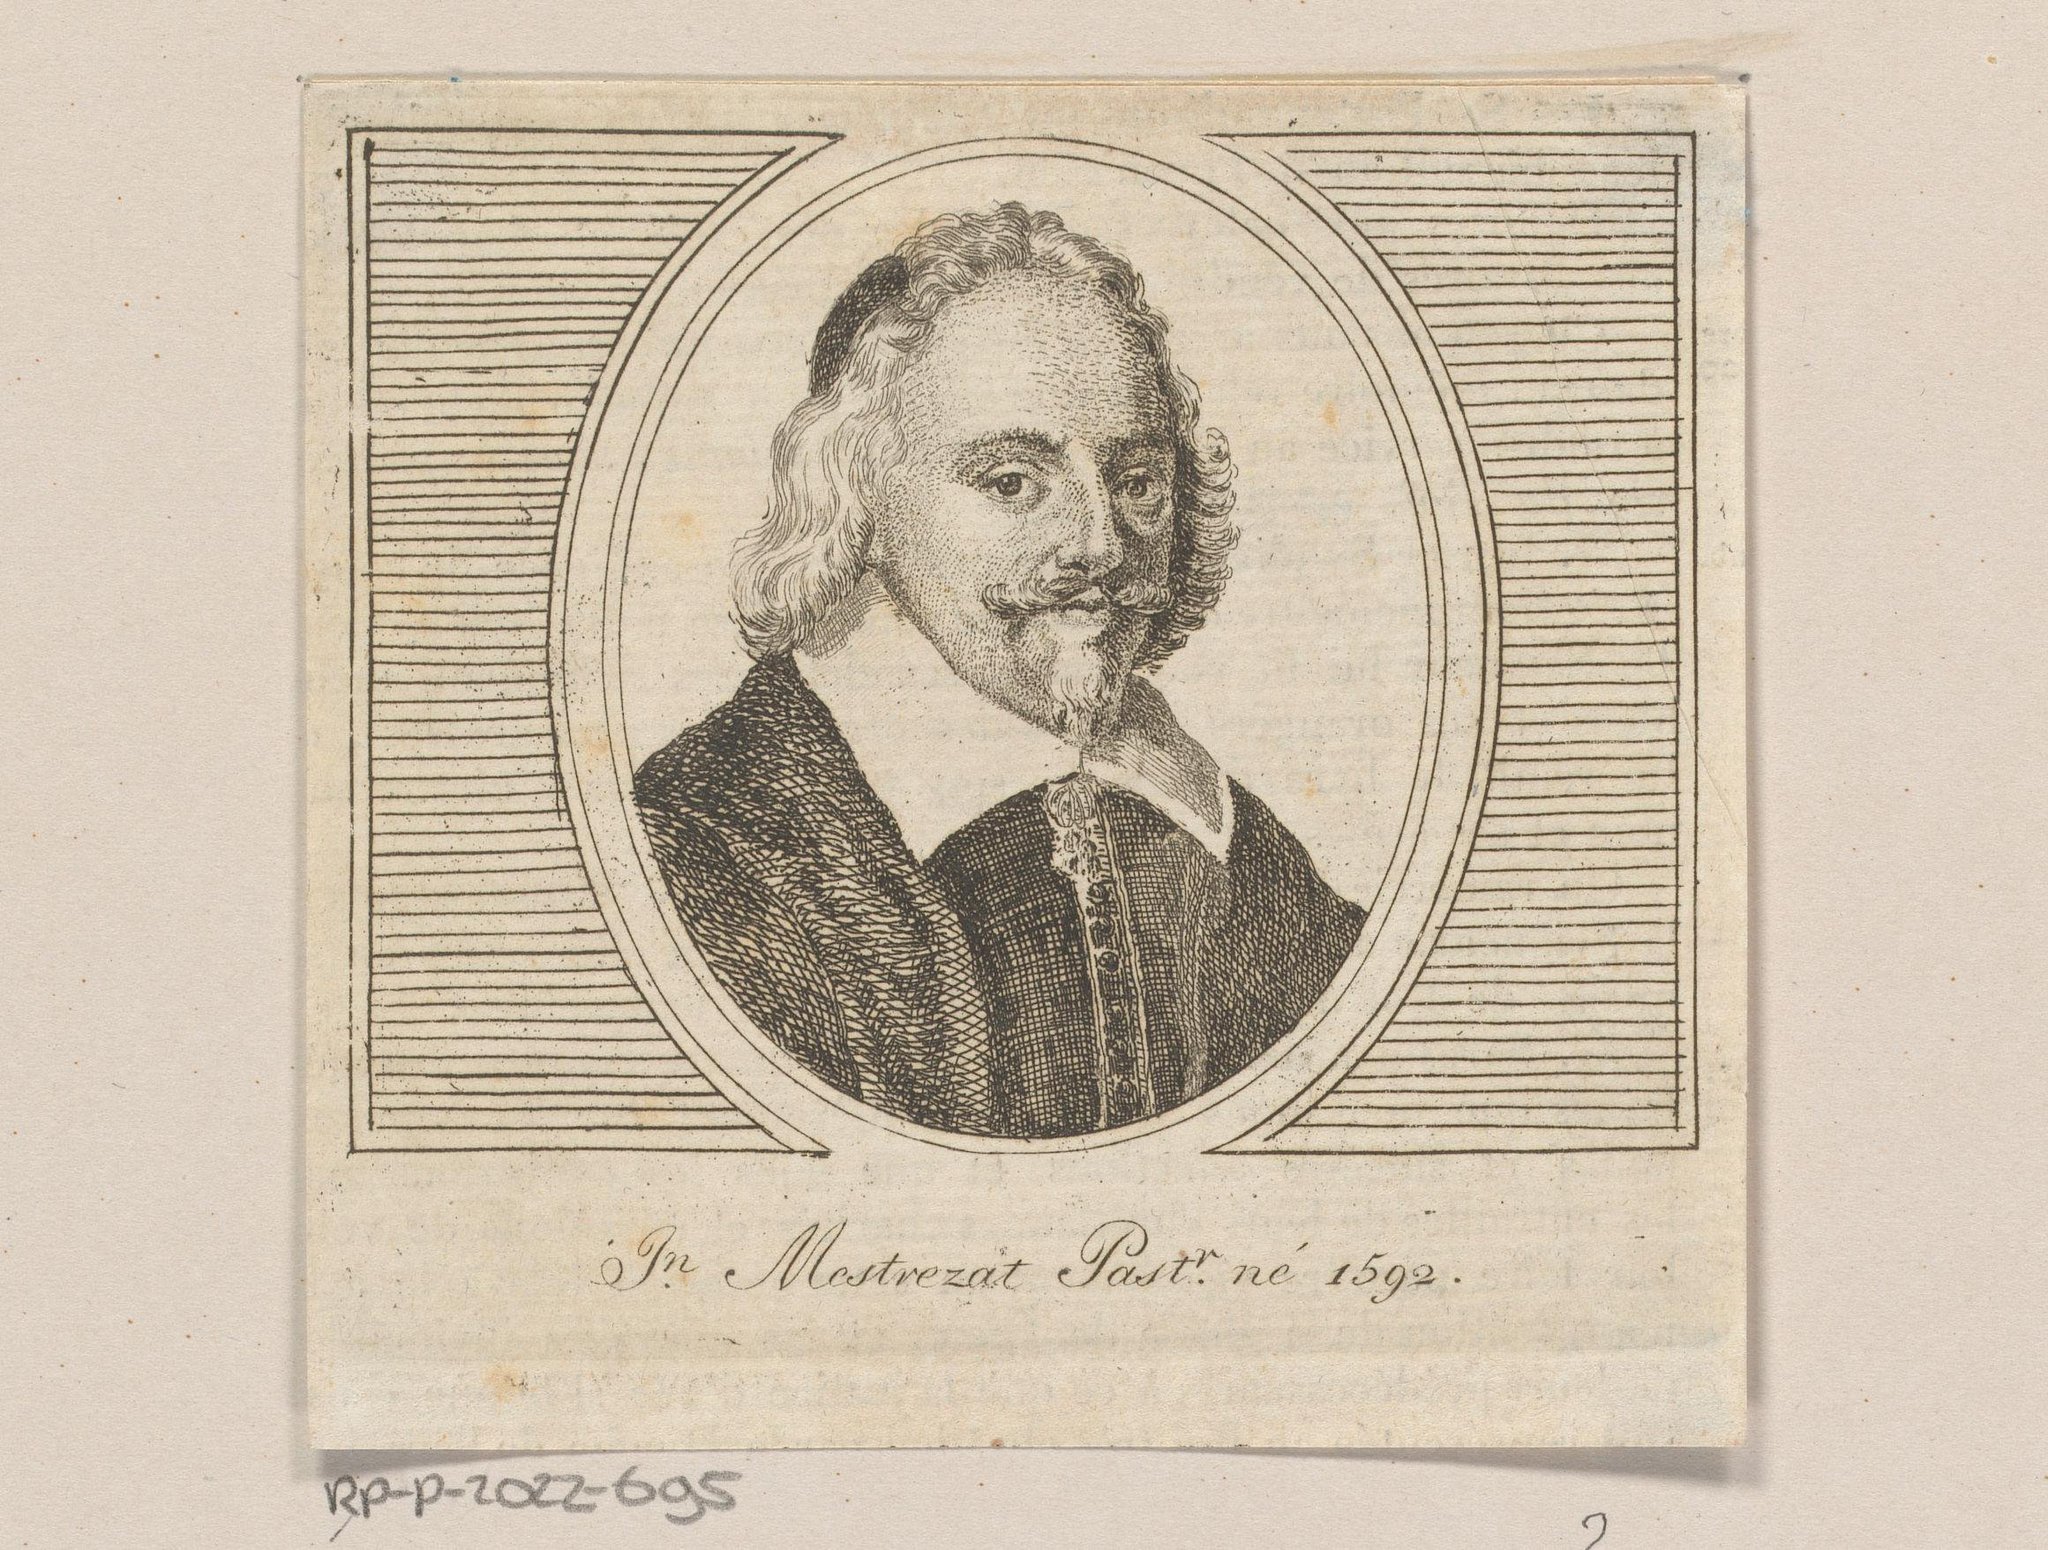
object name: book illustration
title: In. Mestrezat Pastr.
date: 1815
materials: paper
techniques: etching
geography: geneva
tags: historical persons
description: Prent uit: Fragmens Biographiques et Historiques(...). Genève: Manget et Cherubliez, 1815, p. 129.